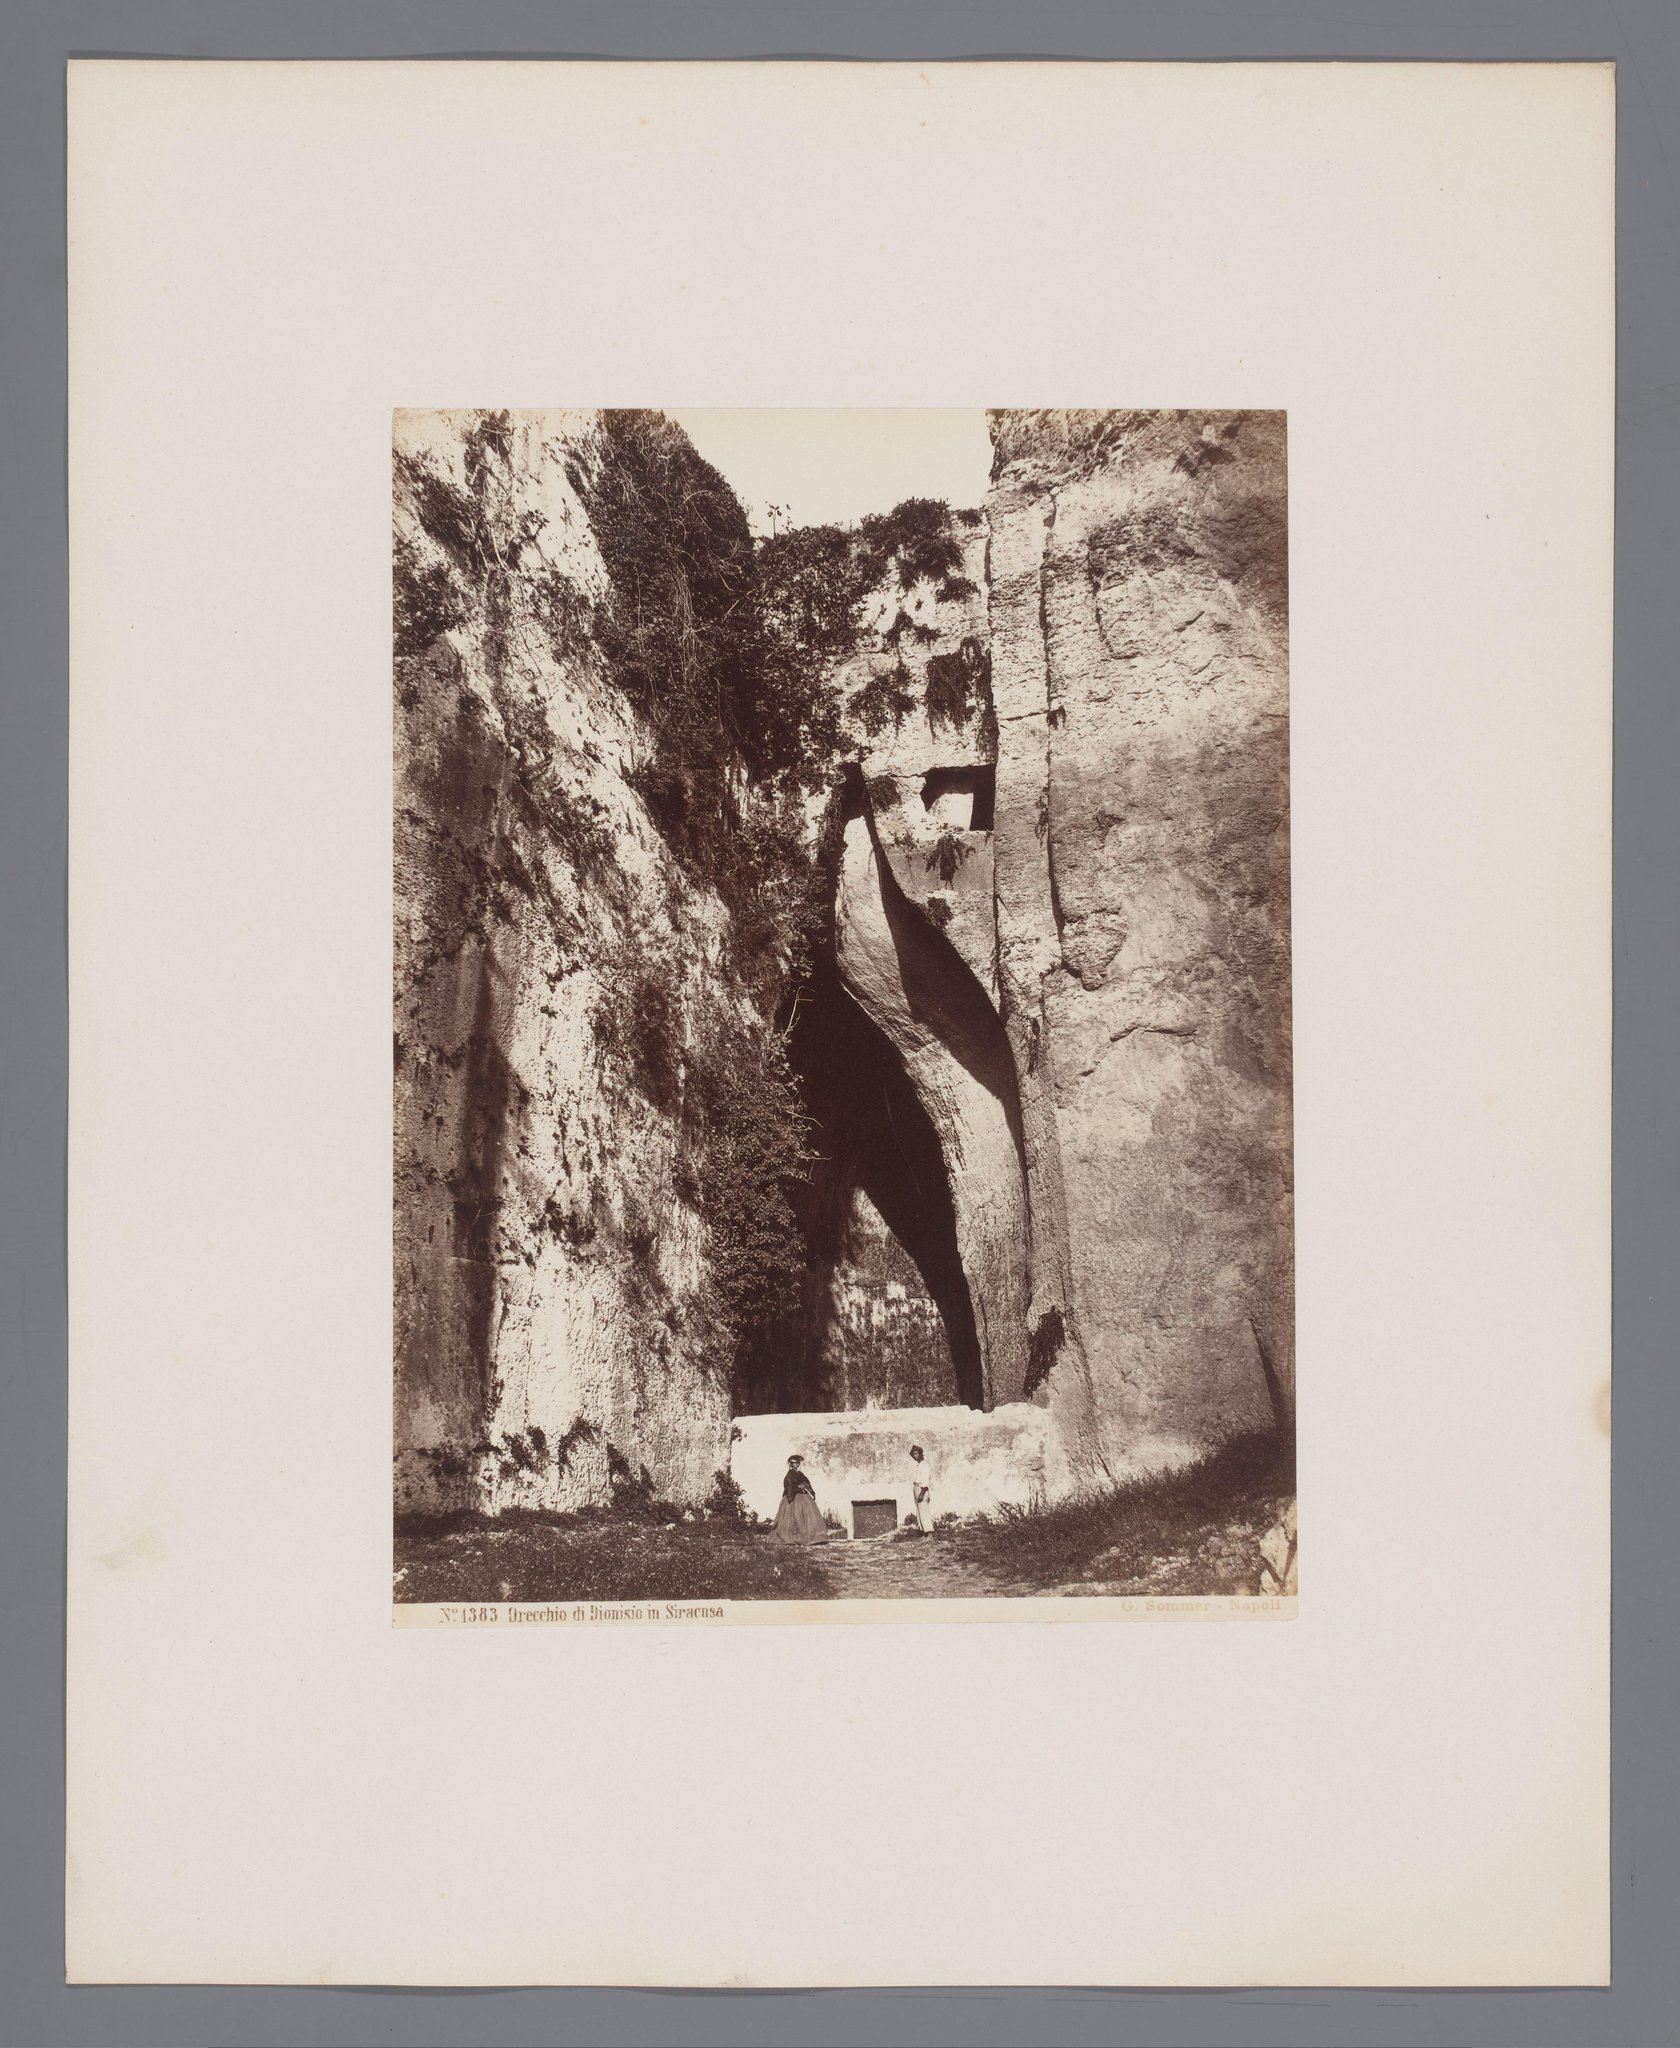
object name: photograph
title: Orecchio di Dionisio in Siracusa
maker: giorgio sommer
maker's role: fotograaf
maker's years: 1834-1914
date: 1857-1914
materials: cardboard, paper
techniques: albumen print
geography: syracuse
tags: cave, grotto, mountains (+ landscape with figures, staffage)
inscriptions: number: ‘No. 1383’